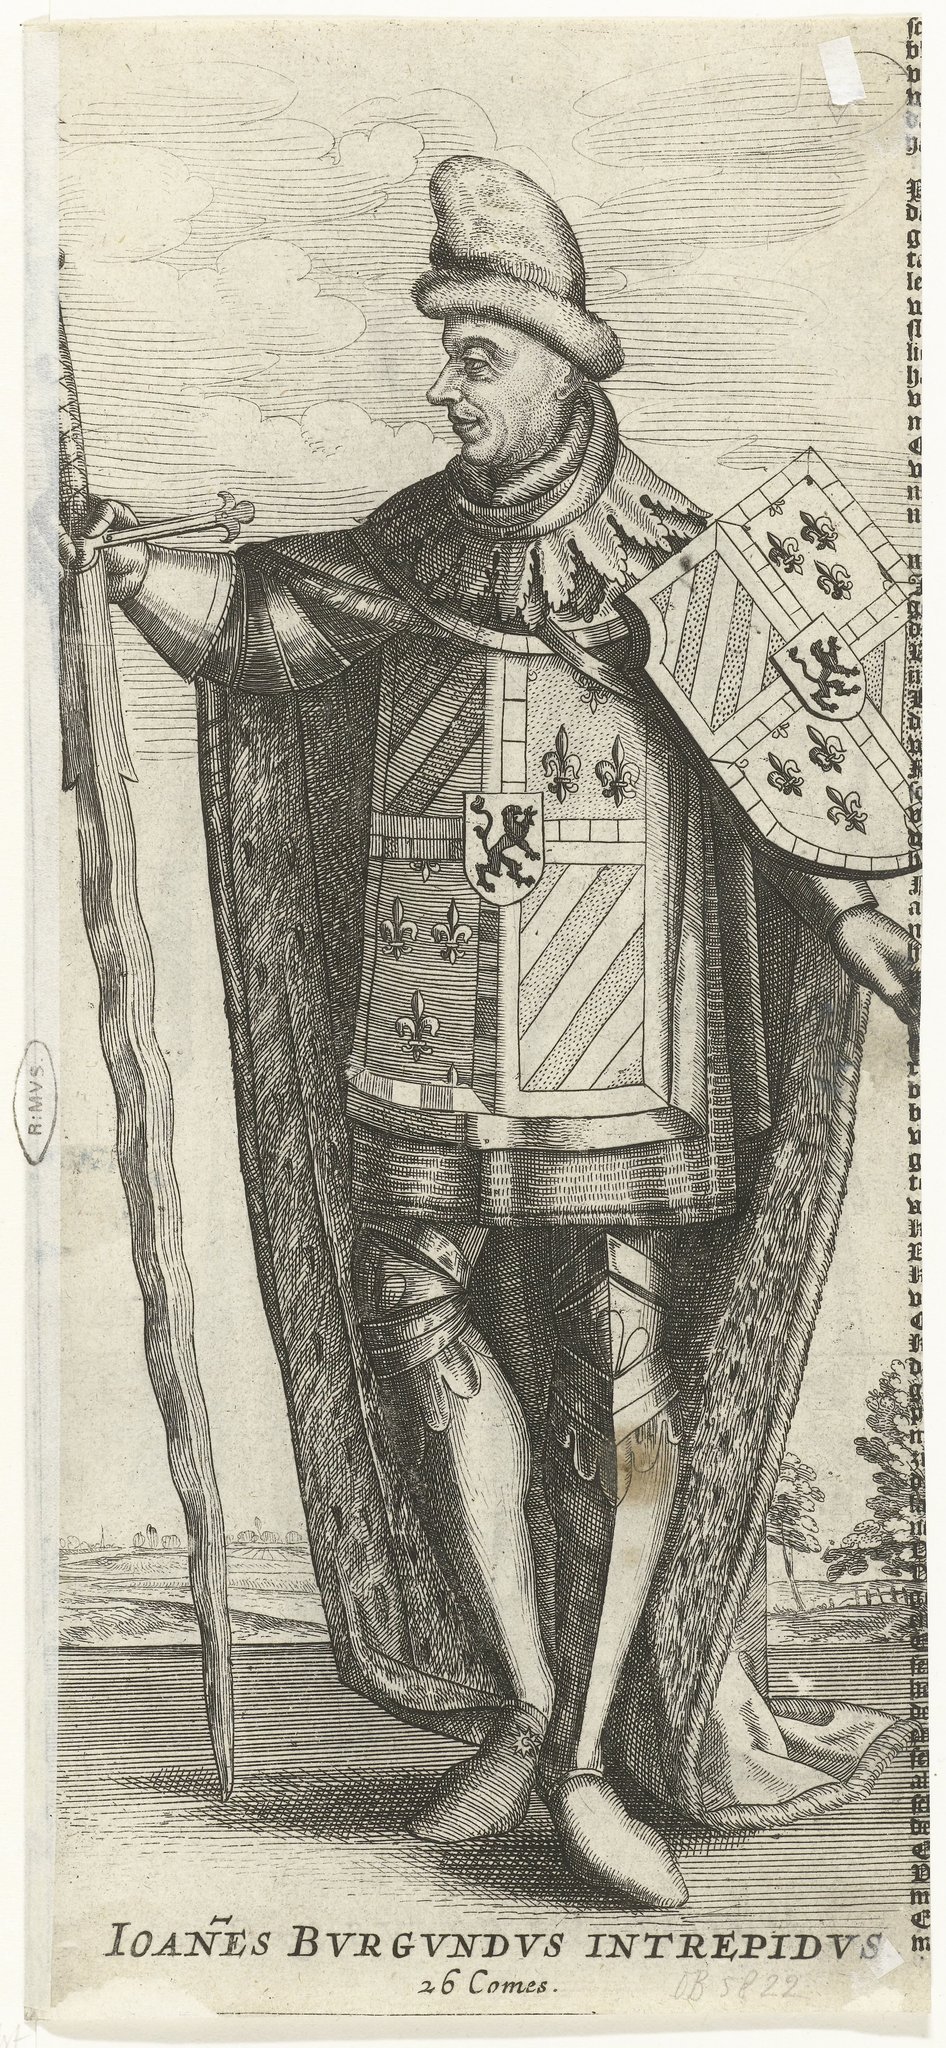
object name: book illustration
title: Philippvs Bonvs 27 Comes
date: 1628-1688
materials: paper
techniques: etching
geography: amsterdam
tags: montereau-fault-yonne, hertog, jan zonder vrees (hertog van bourgondië)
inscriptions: collector's mark: Lugt 2228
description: Portret van Jan zonder Vrees, hertog van Bourgondië. Staande, ten voeten uit. In zijn rechterhand het rijkszwaard en in zijn linkerhand zijn wapenschild.